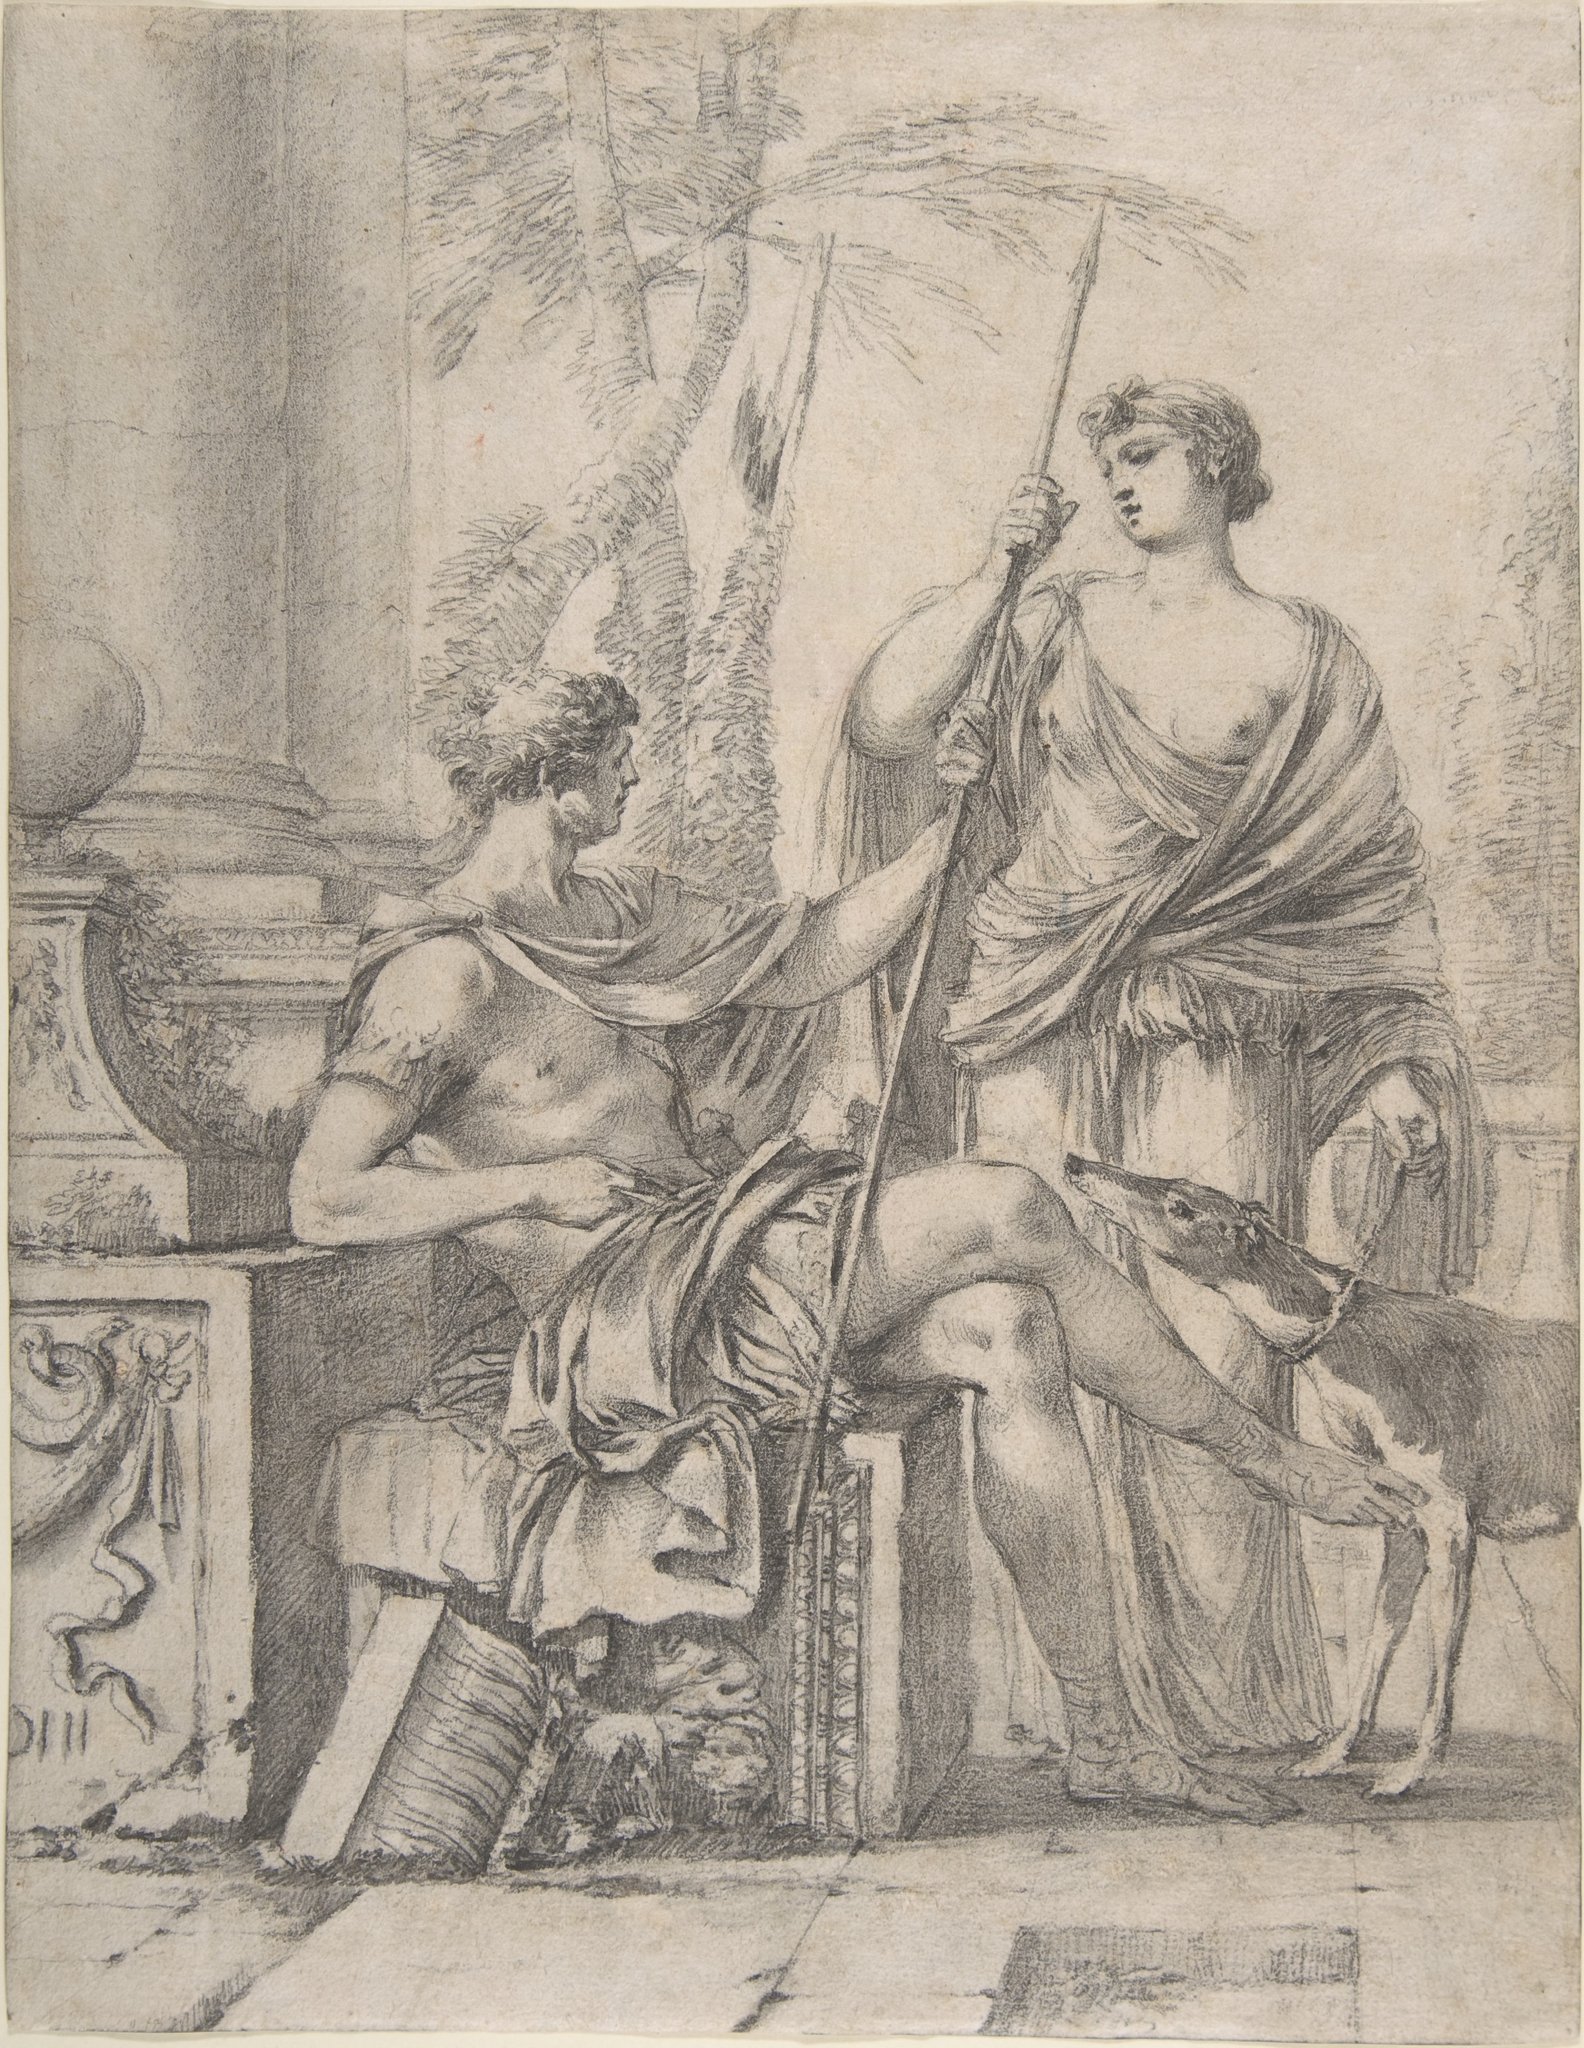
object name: drawing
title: Cephalus Receiving the Spear and Hound from Procris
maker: laurent de la hyre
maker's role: artist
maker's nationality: french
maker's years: 1606-1656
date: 1644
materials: chalk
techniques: brush, wash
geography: france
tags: men,female nudes,dogs